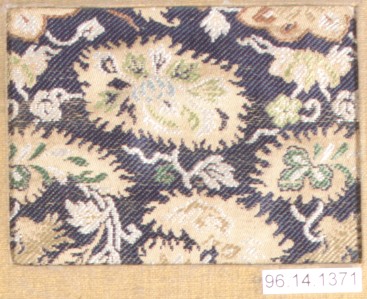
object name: piece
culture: japanese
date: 1701-1900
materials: silk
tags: flowers